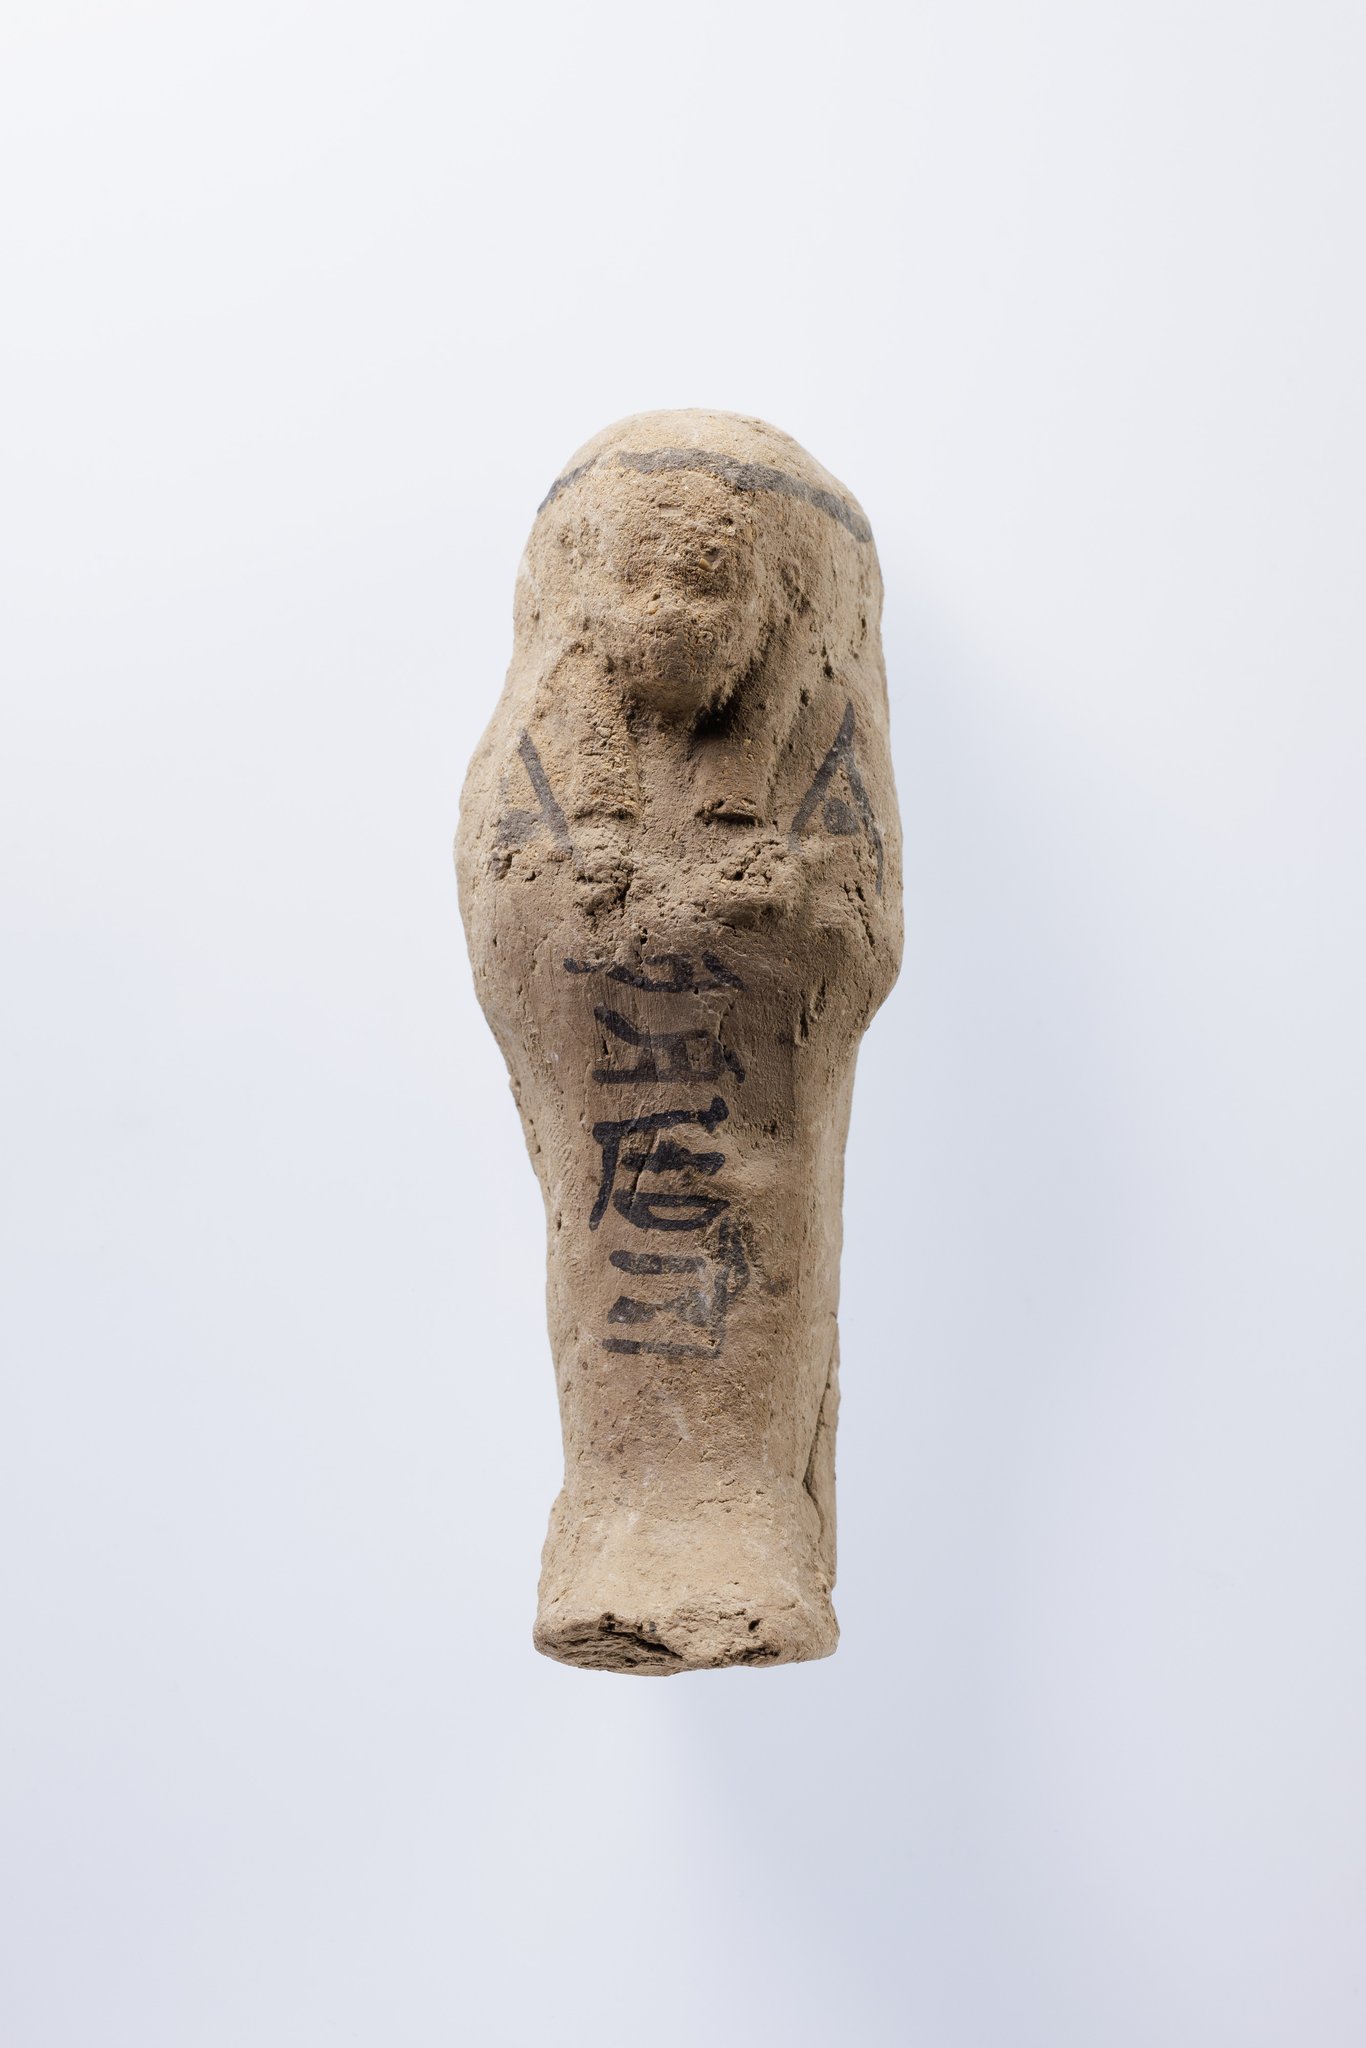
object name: shabti, nesinebtasheru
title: Shabti of Nesinebtasheru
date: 1070-945 BCE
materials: clay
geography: egypt